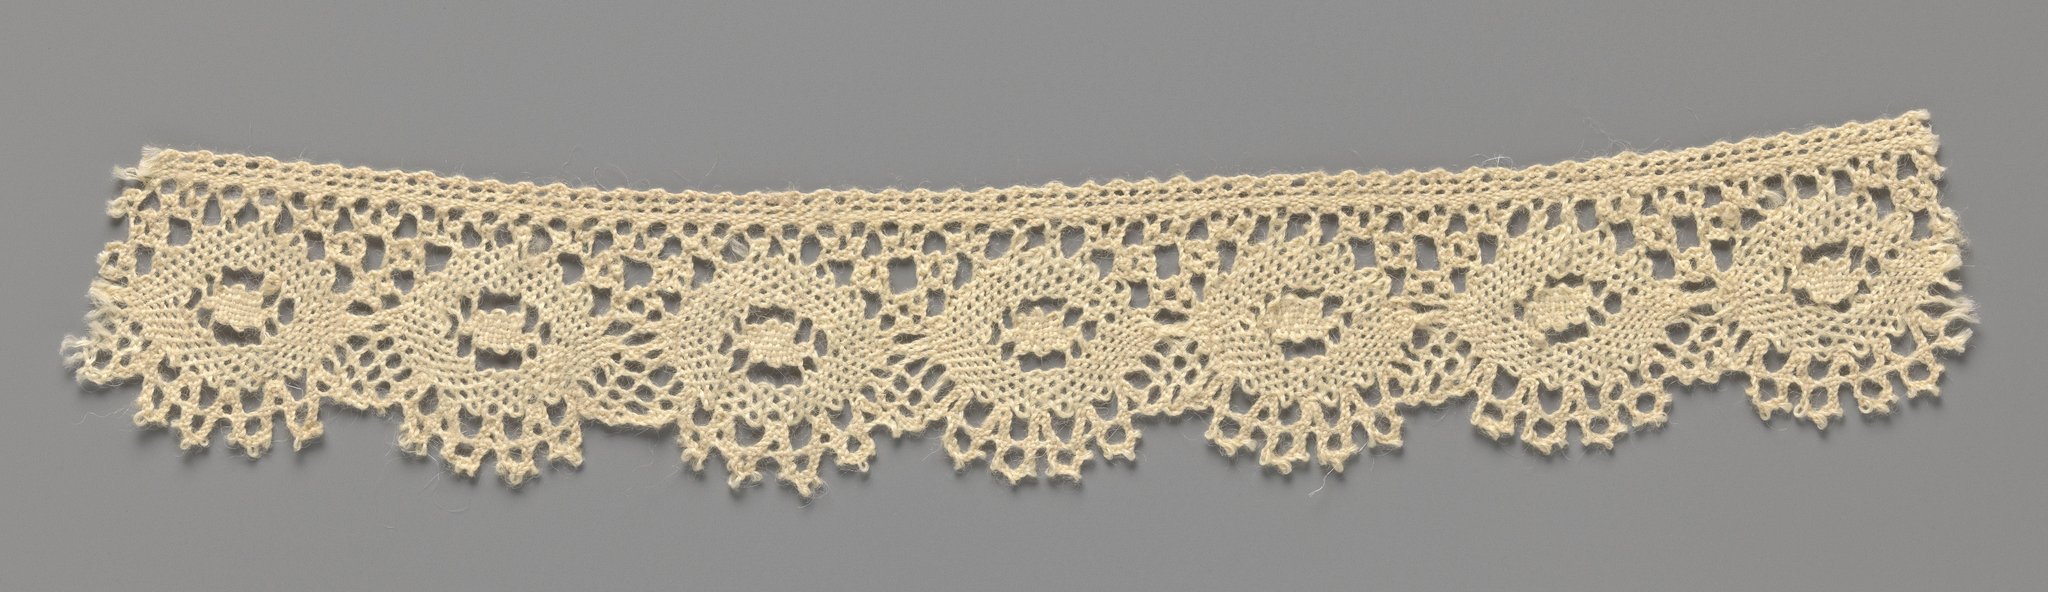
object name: strip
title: Strook kloskant met een rij ovalen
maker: Anonymous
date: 1875-1899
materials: wool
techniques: lace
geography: le puy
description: Strook naturelkleurige kloskant: stropkant. Het zich herhalende en symmetrische patroon bestaat uit één rij ovalen. De ovalen zijn gemaakt in netslag met in het centrum een kleiner ovaal gemaakt in linnenslag. Ze zijn aan de bovenkant met elkaar verbonden door een vijfgaatjesgrond en aan de onderkant door een stroptraliegrond, beide gronden zijn spaarzaam toegepast. De ovalen vormen de schulpenrand, met onderaan elk ovaal vier boogjes gemaakt met een doorlopend slingerend vlechtje. De bovenzijde van de strook is recht afgewerkt.